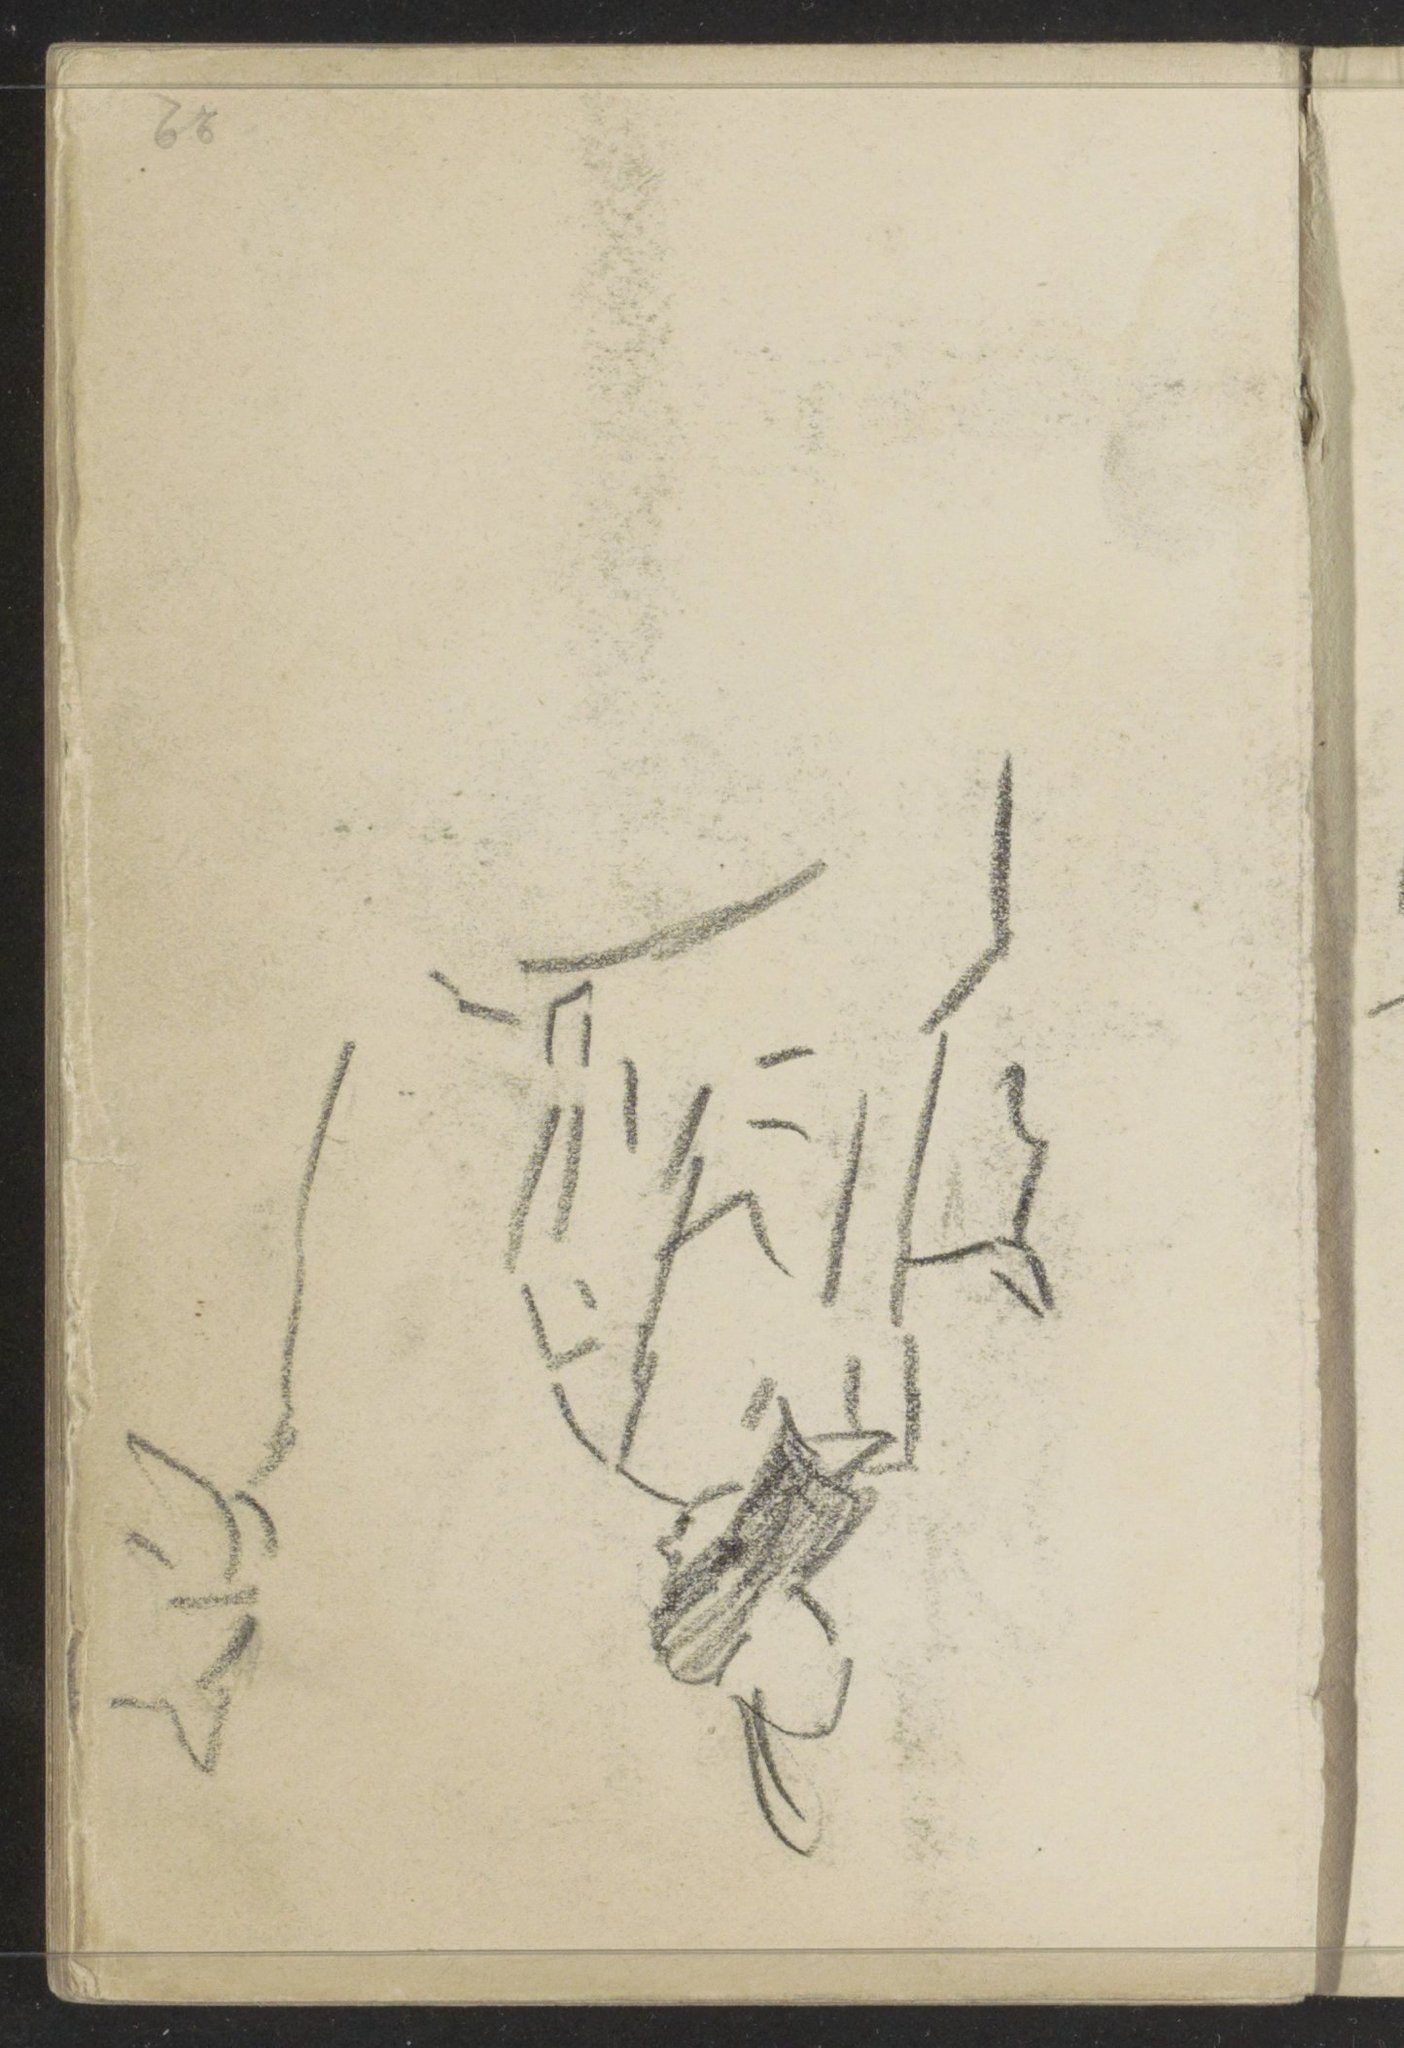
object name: sketchbook leaf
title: Ruiter, op de rug gezien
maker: isaac israels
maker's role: draughtsman, painter, print maker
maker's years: 1865-1934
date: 1887-1934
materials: chalk, paper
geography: paris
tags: riding a horse, ass, or mule; rider, horseman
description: Blad 21 recto uit schetsboek LIX met 21 bladen.